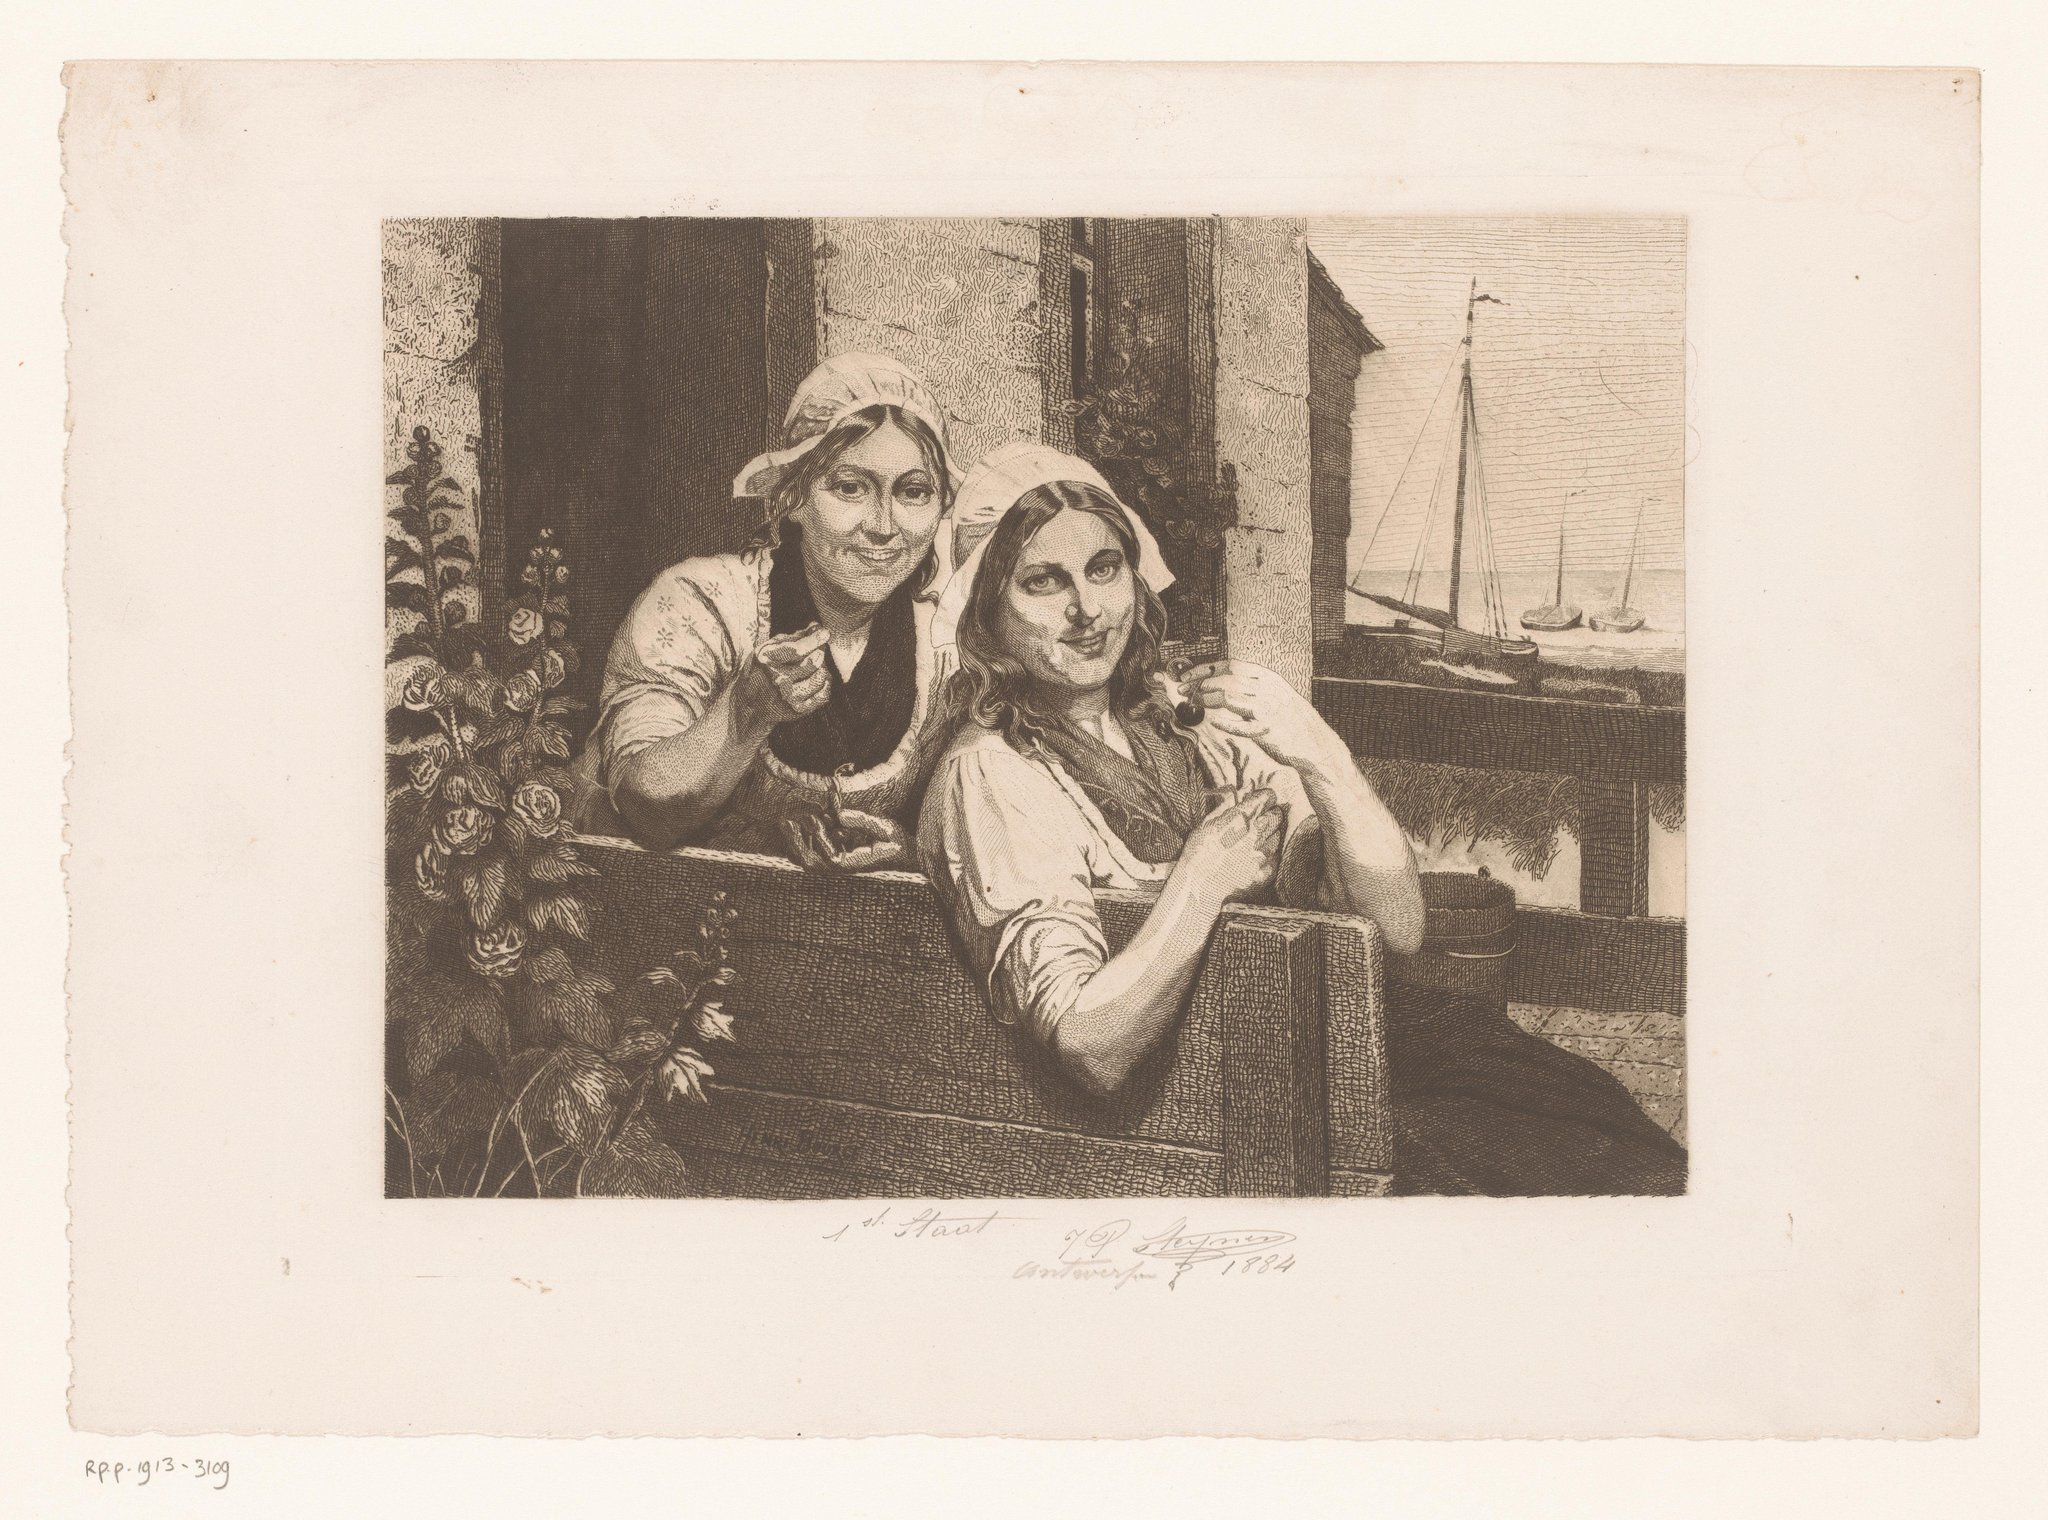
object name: print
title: Twee boerinnen met kersen in de hand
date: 1884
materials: paper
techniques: aquatint, etching, retroussage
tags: farmers - aa - female farmer, farmer's wife, fruits: cherry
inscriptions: inscription: ‘1 st. Staat, Antwerpen 1884’, collector's mark: Lugt 2228